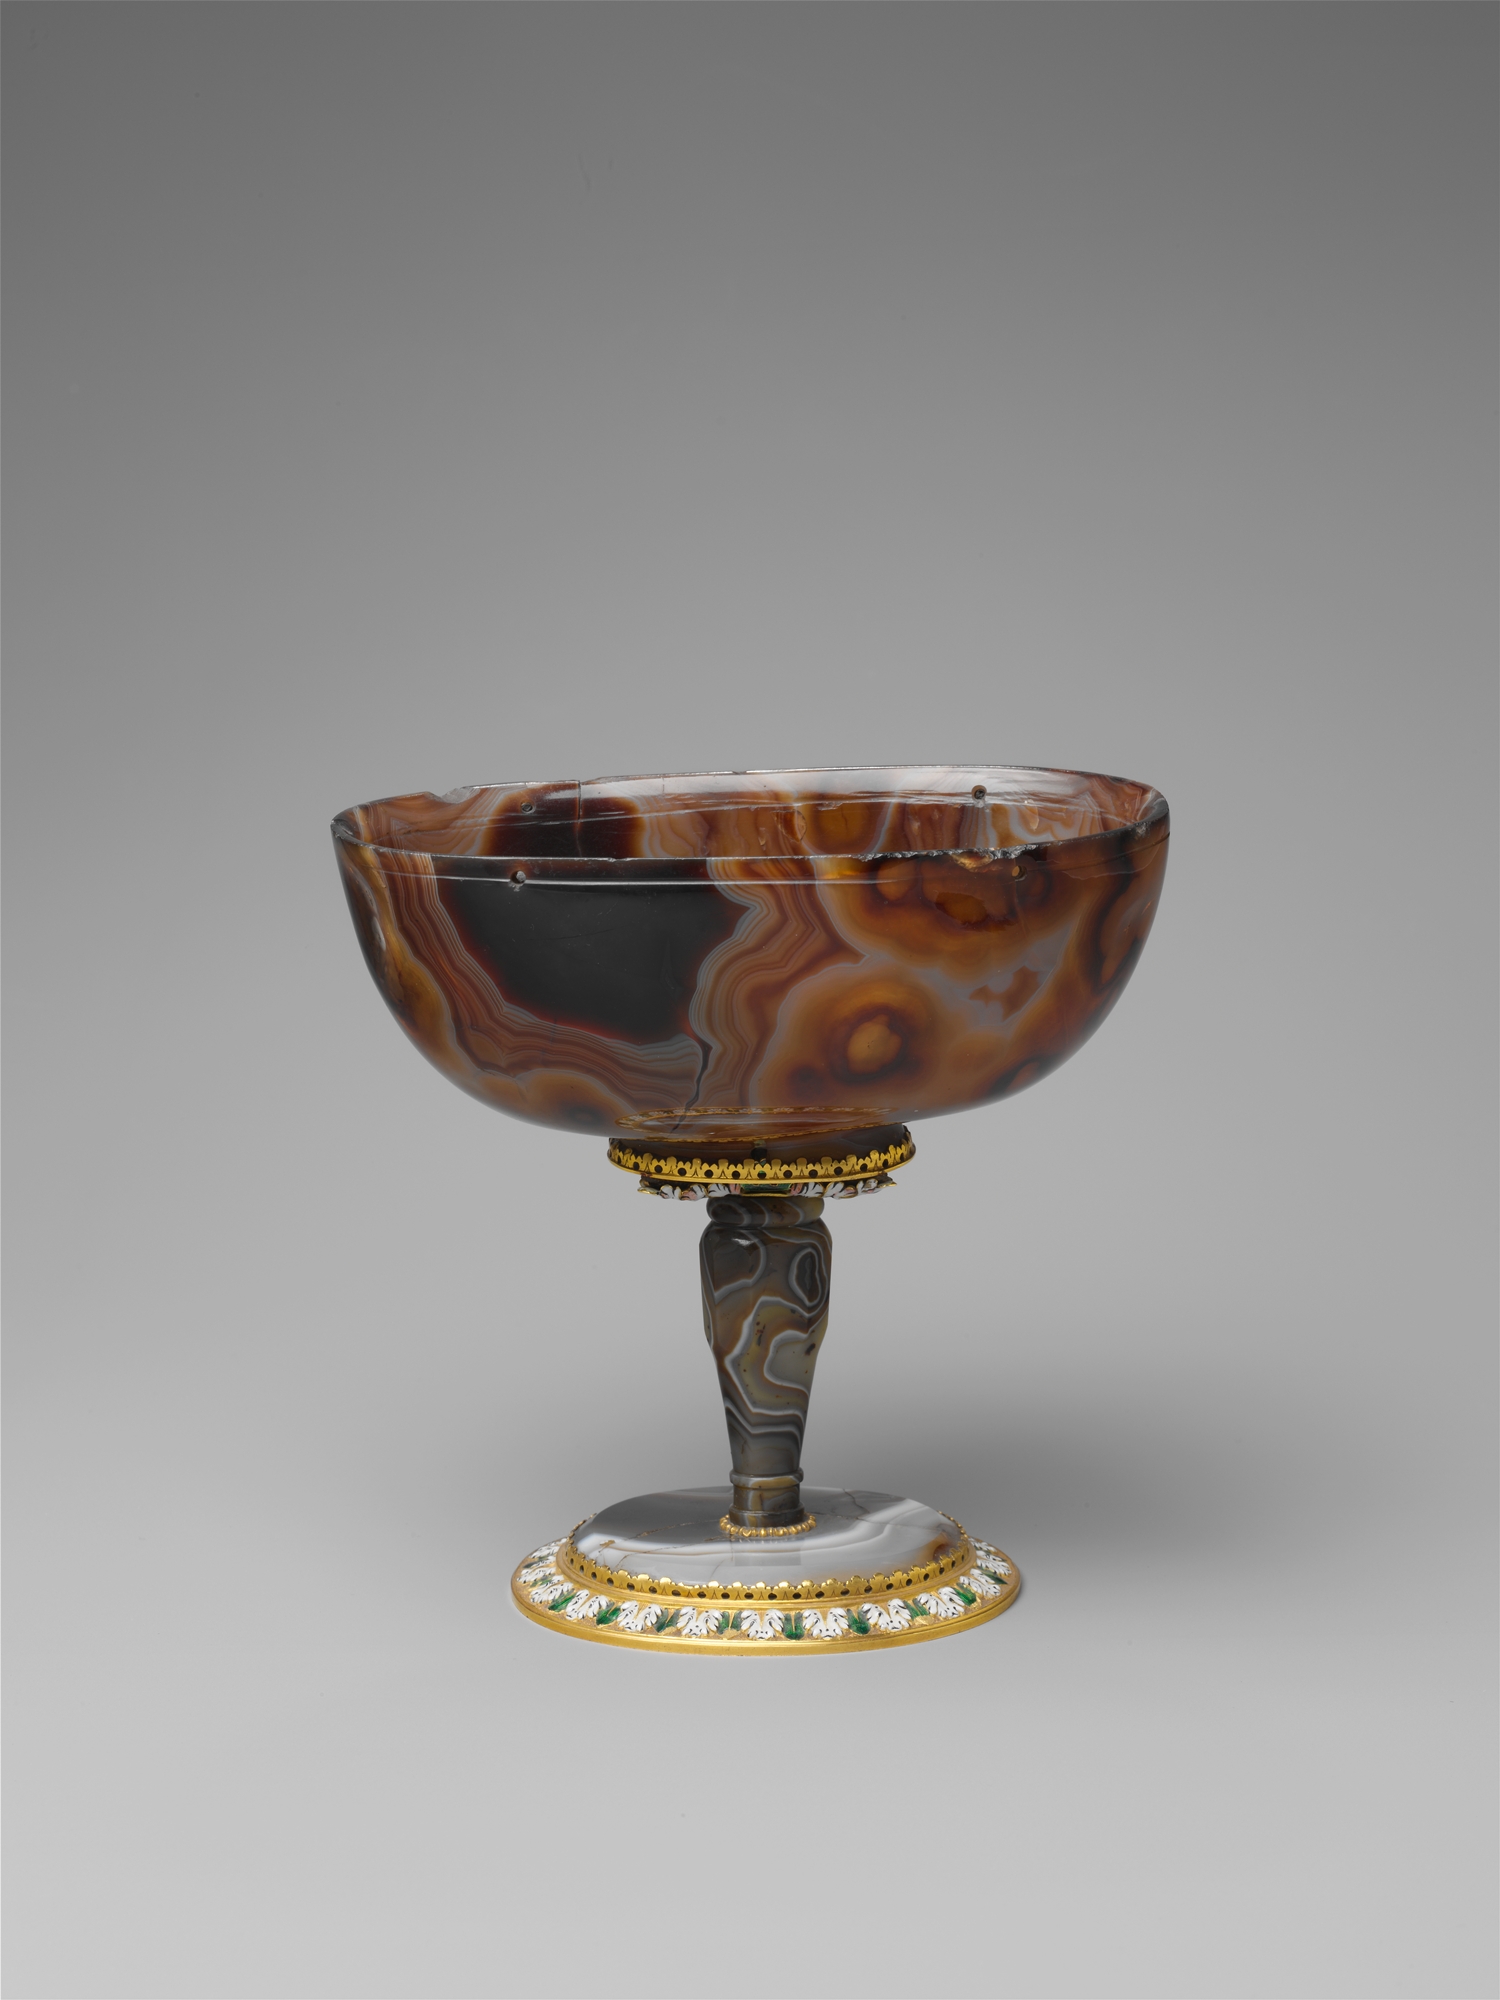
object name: cup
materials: enamel, gold, gemstone